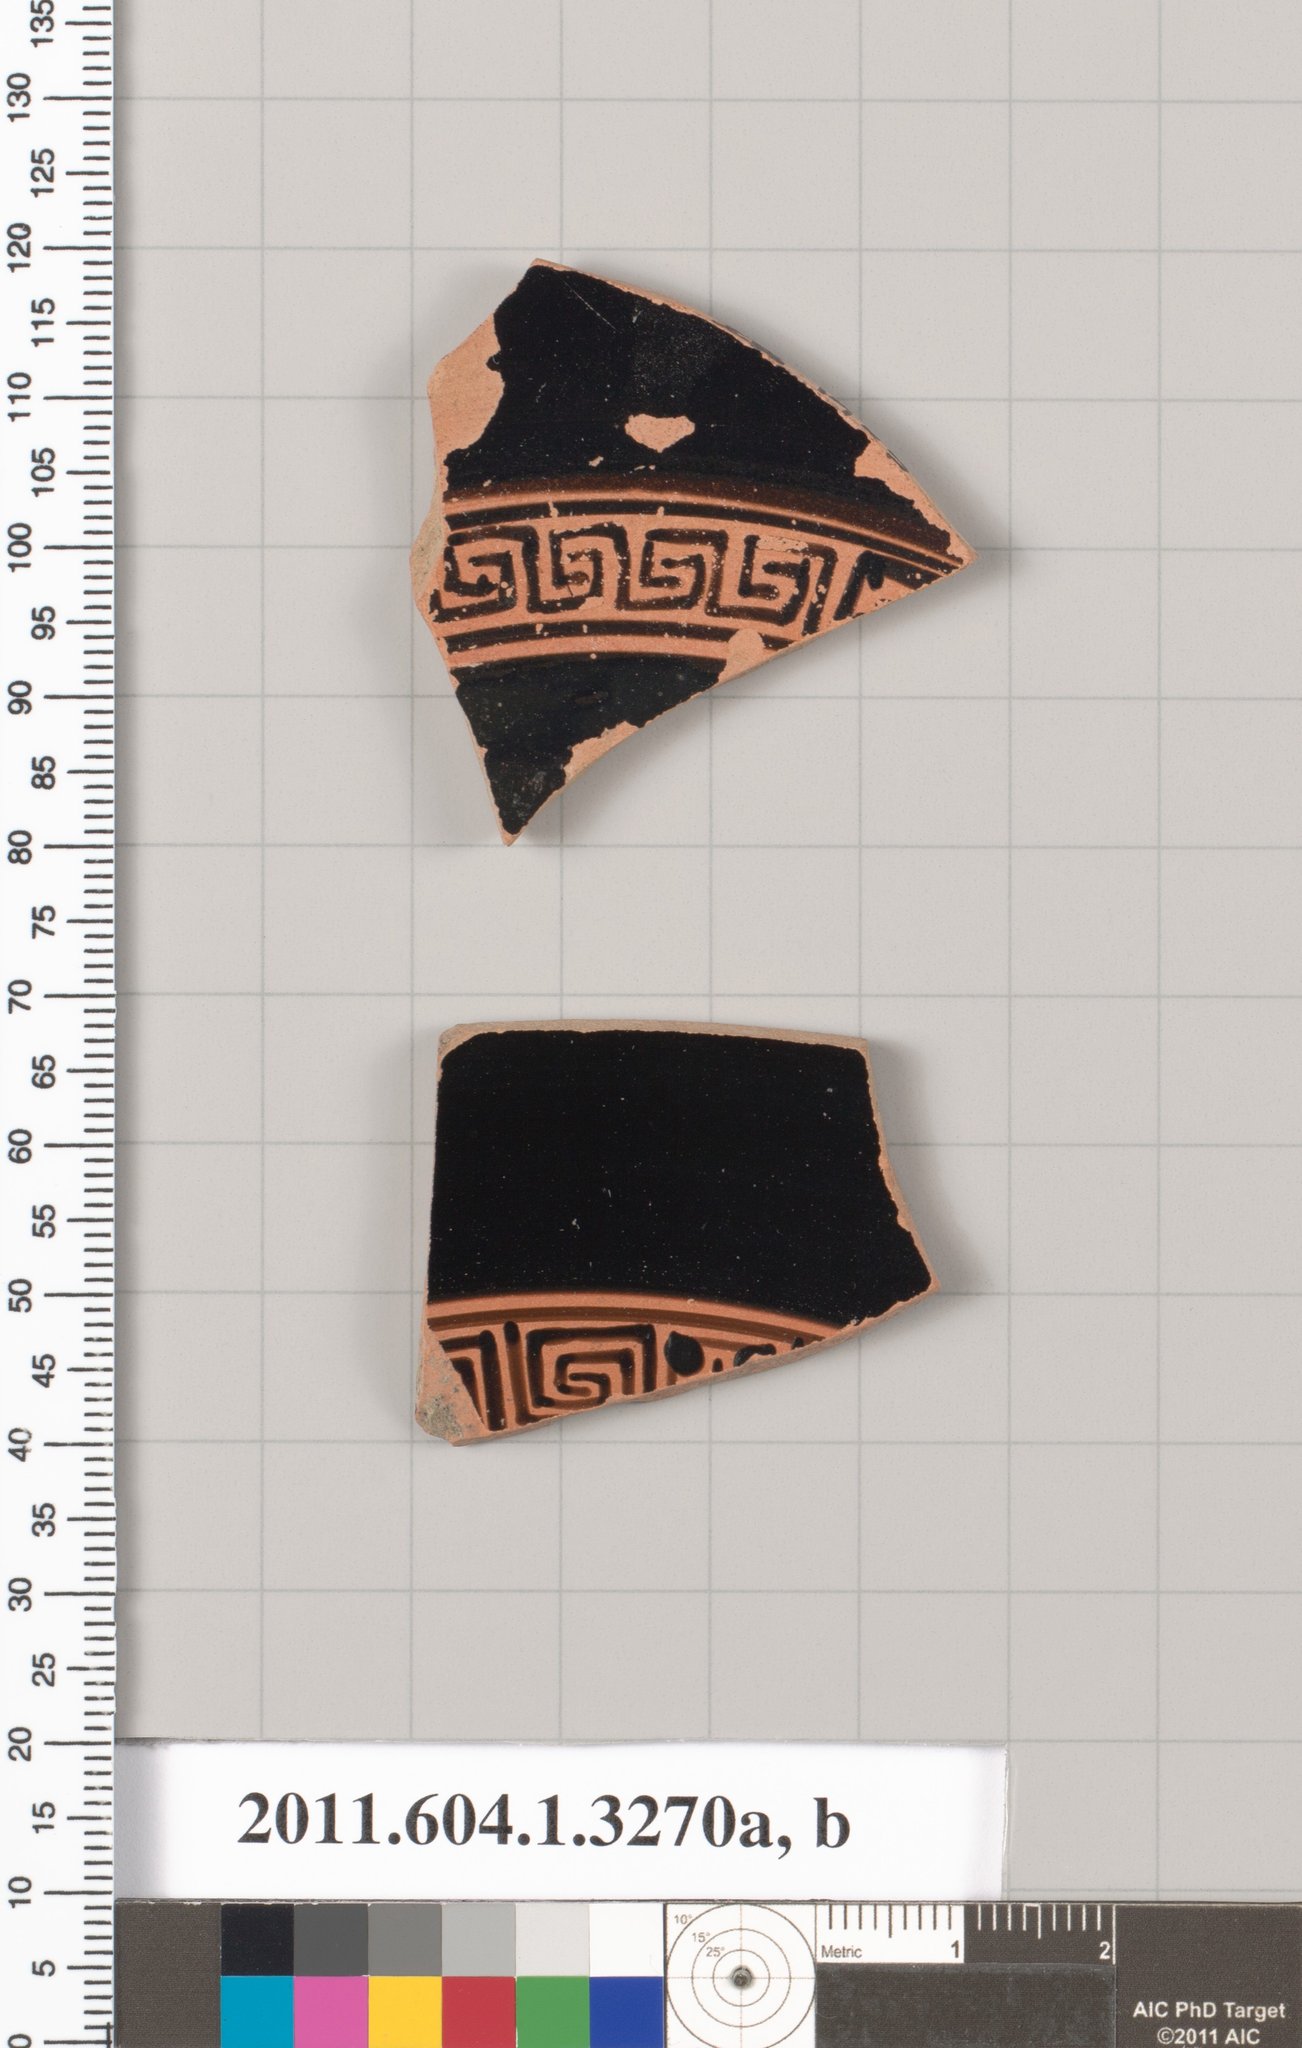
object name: kylix fragment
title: Terracotta fragments of kylikes (drinking cups)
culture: greek, attic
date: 500-490 BCE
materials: terracotta